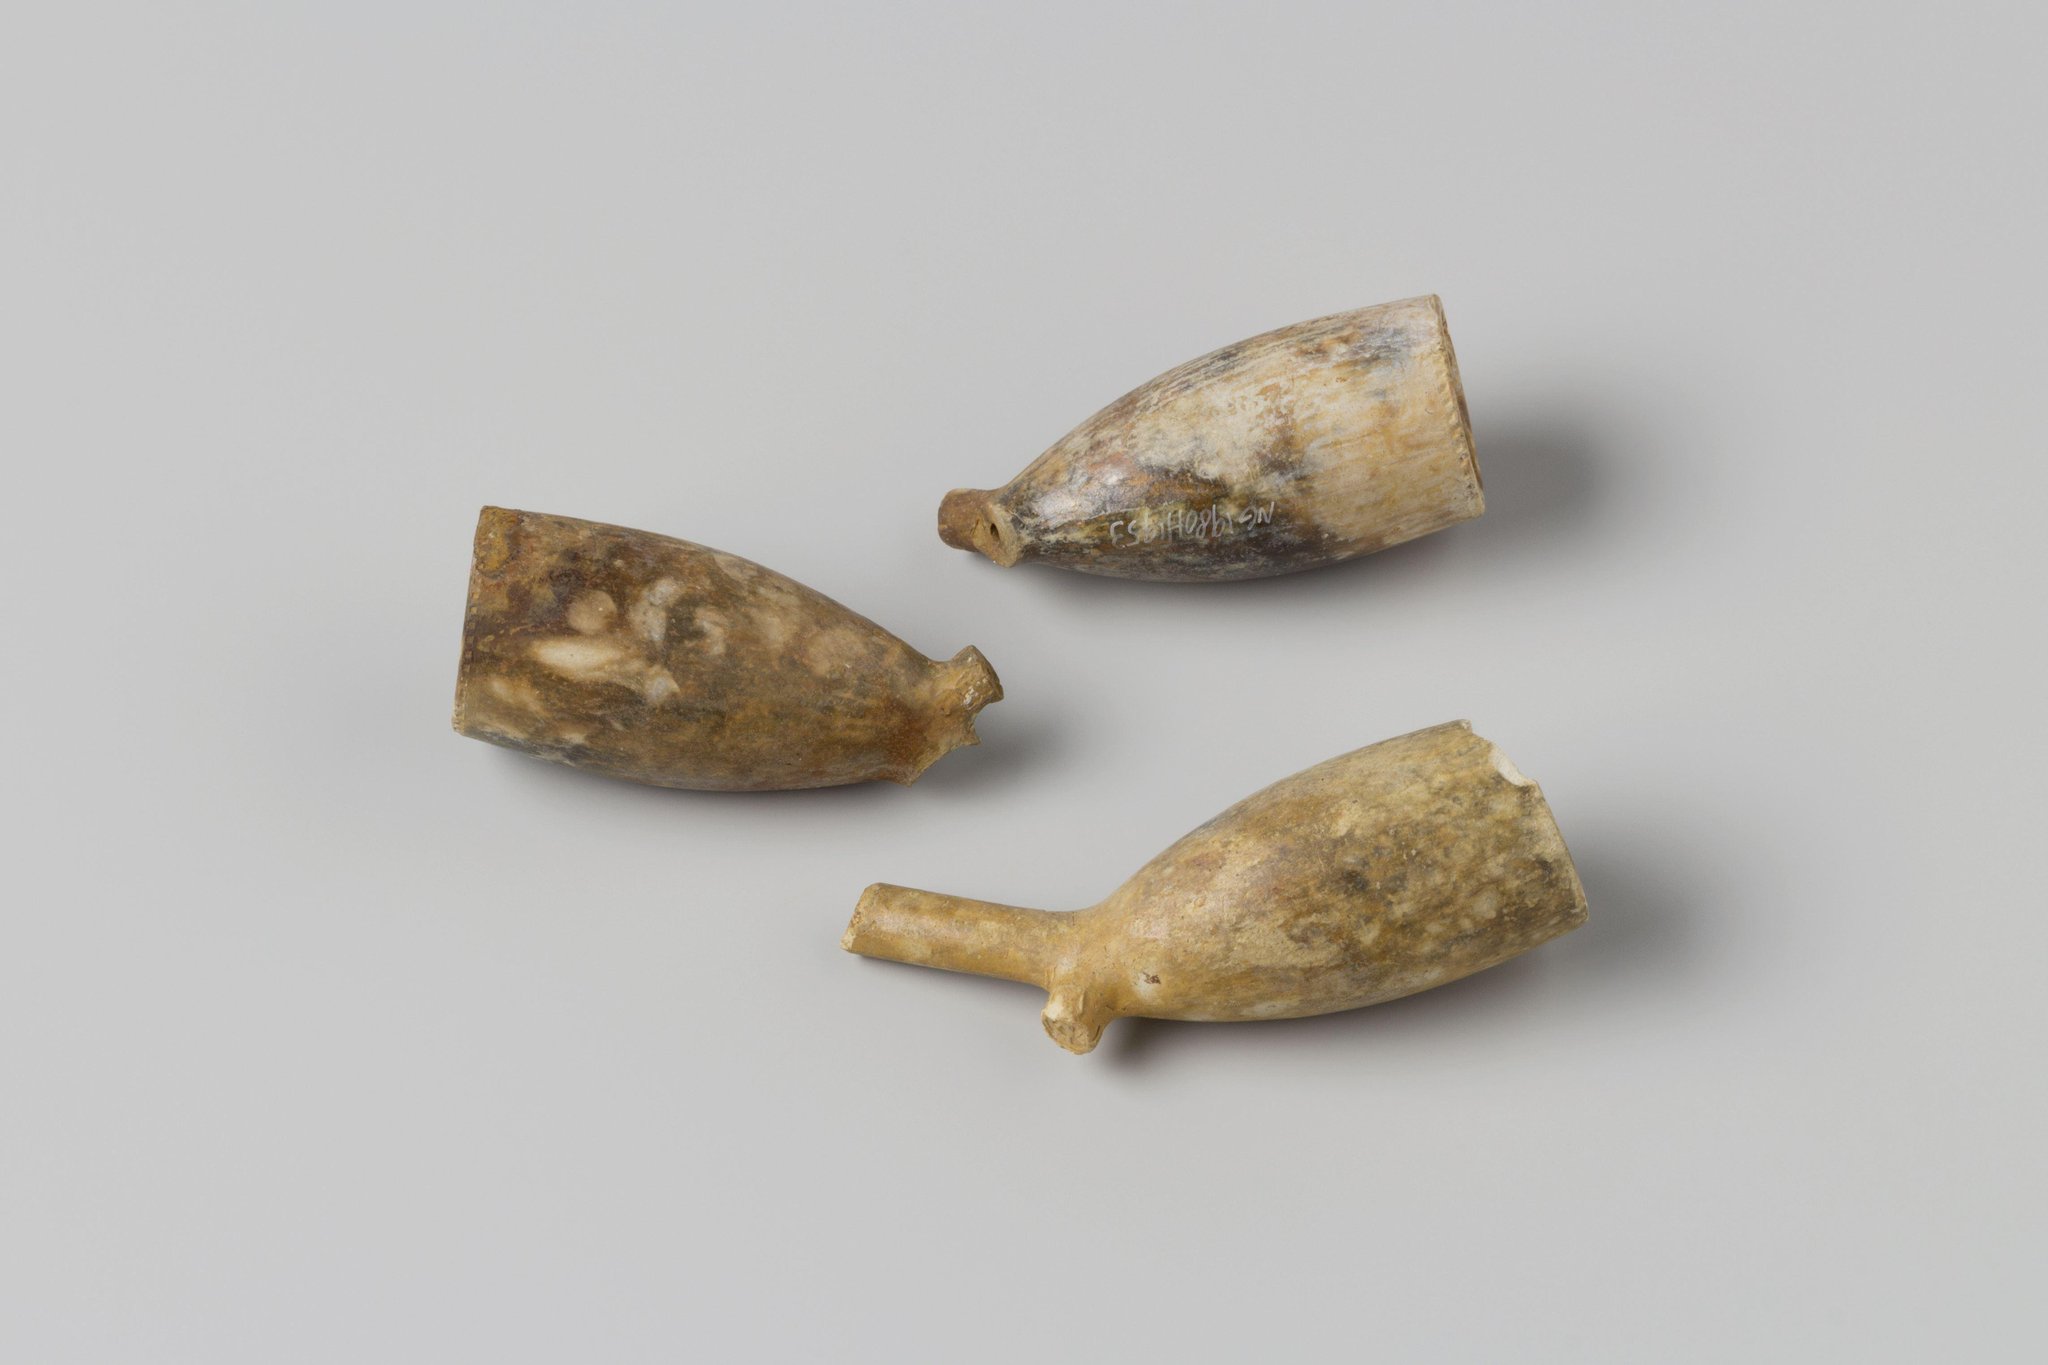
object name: pipe bowl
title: Pijpenkoppen uit het wrak van de Oost-Indiëvaarder Hollandia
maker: Anonymous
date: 1700-1743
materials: clay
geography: netherlands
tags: verenigde oostindische compagnie, hollandia (schip), annet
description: Pipe, bowl, heelmark: crowned 57; no hsm, 2hsm1,3.